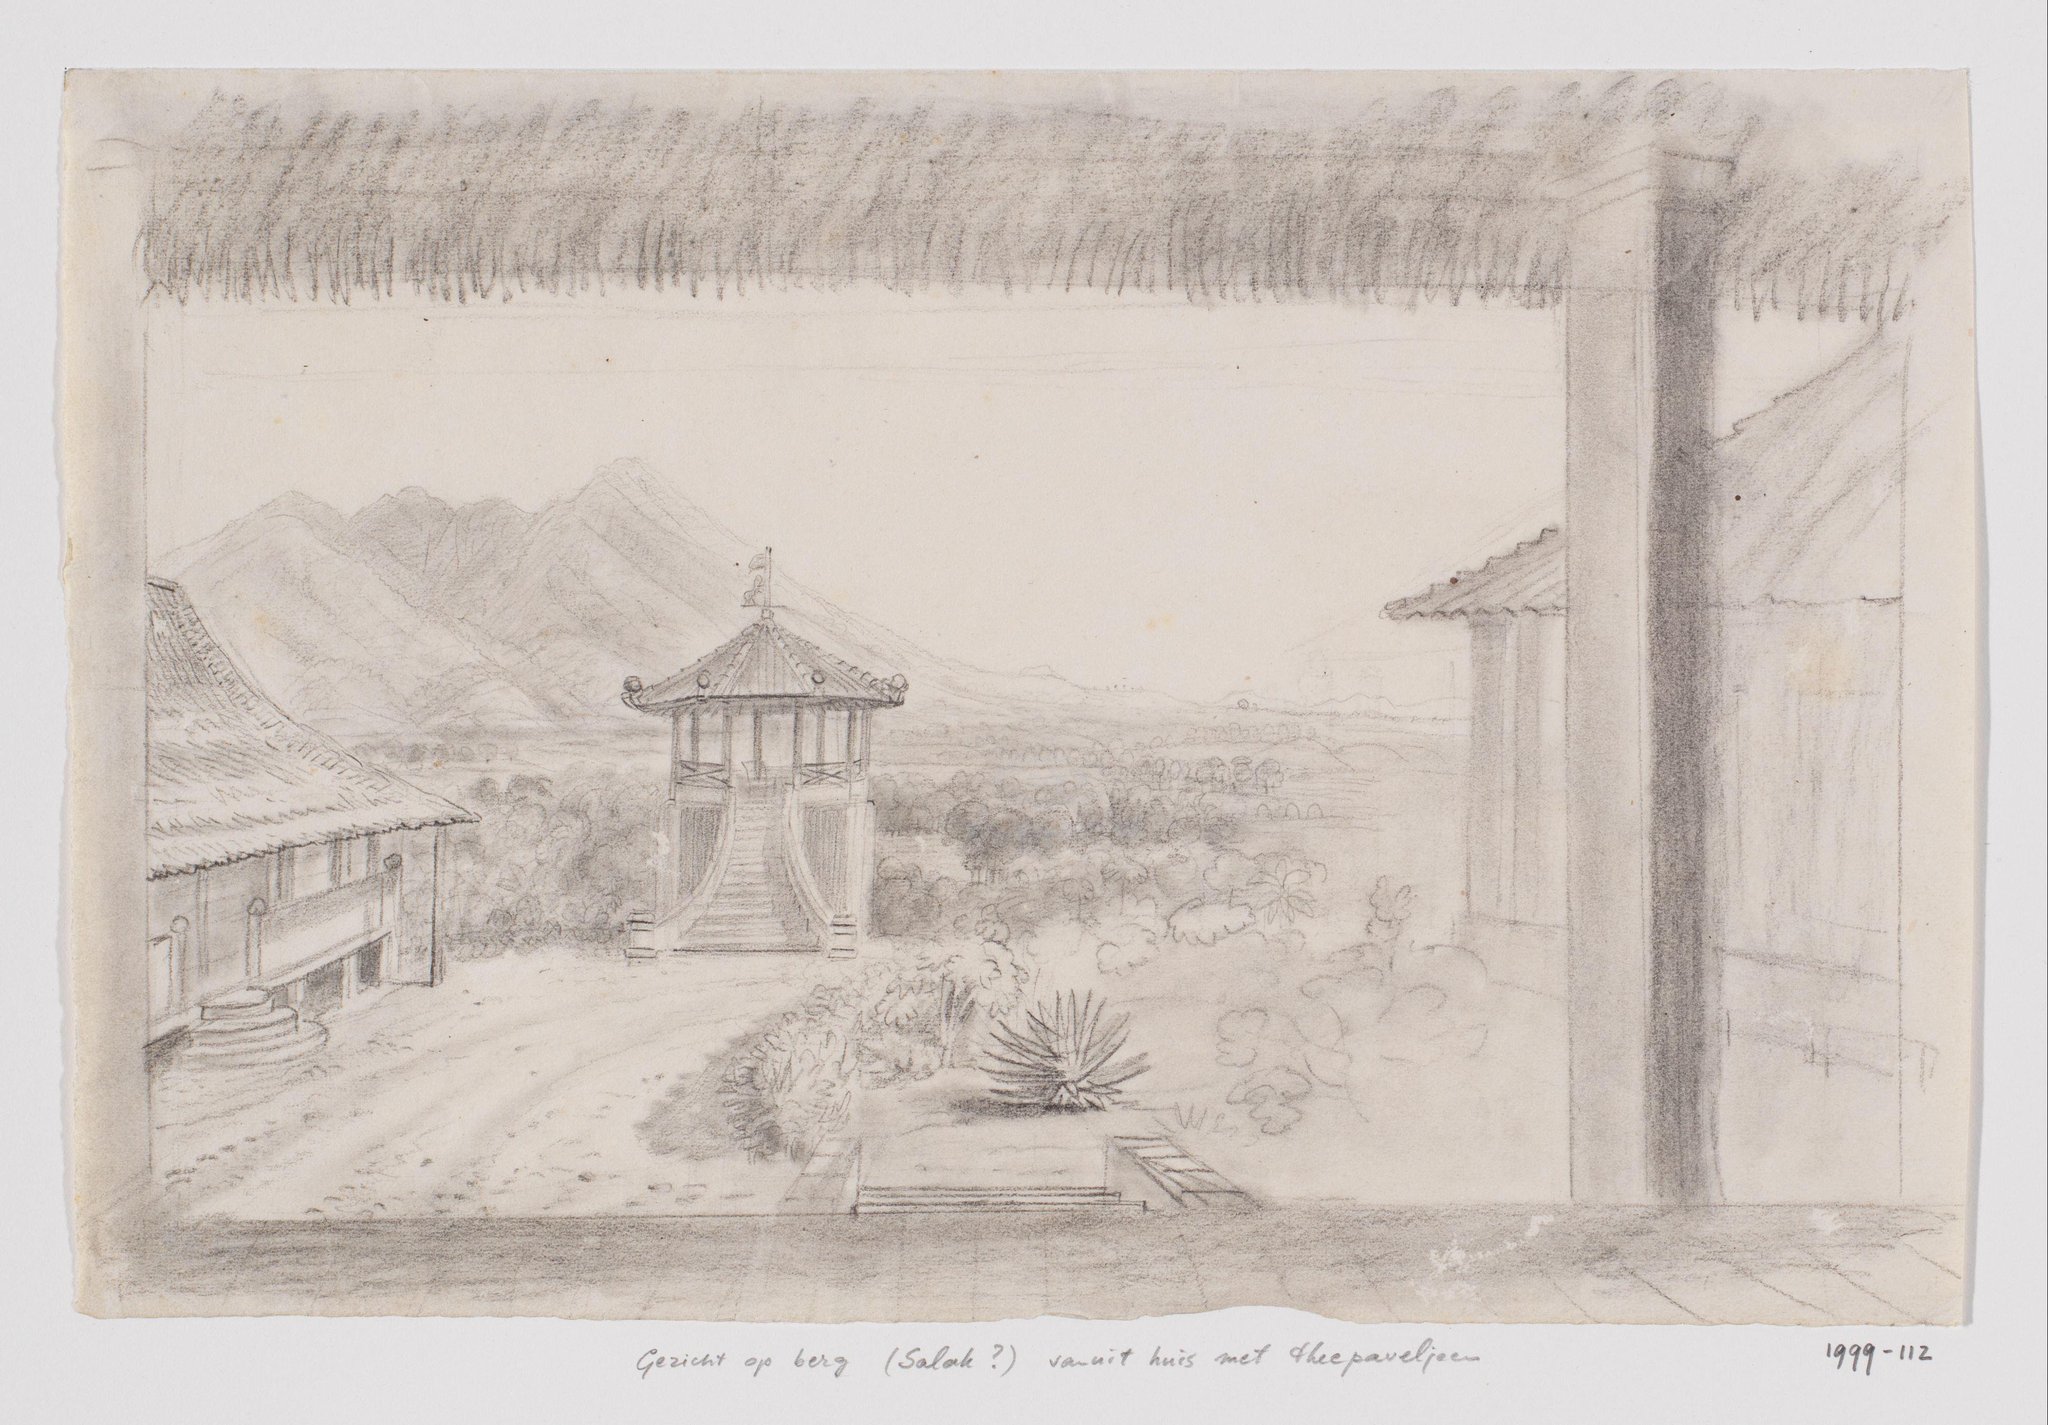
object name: topographical view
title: Gezicht op een berg vanuit een huis met tuinpaviljoentje, West-Java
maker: adrianus johannes bik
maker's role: draughtsman, print maker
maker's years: 1790-1872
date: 1816-1846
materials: chalk, paper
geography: west java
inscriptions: inscription: ‘Nanggoeng?; Buitenzorg. Hotel Bellevue?’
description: Gezicht op een berg (met het profiel van de Salak) vanuit een huis met tuinpaviljoentje, West-Java.